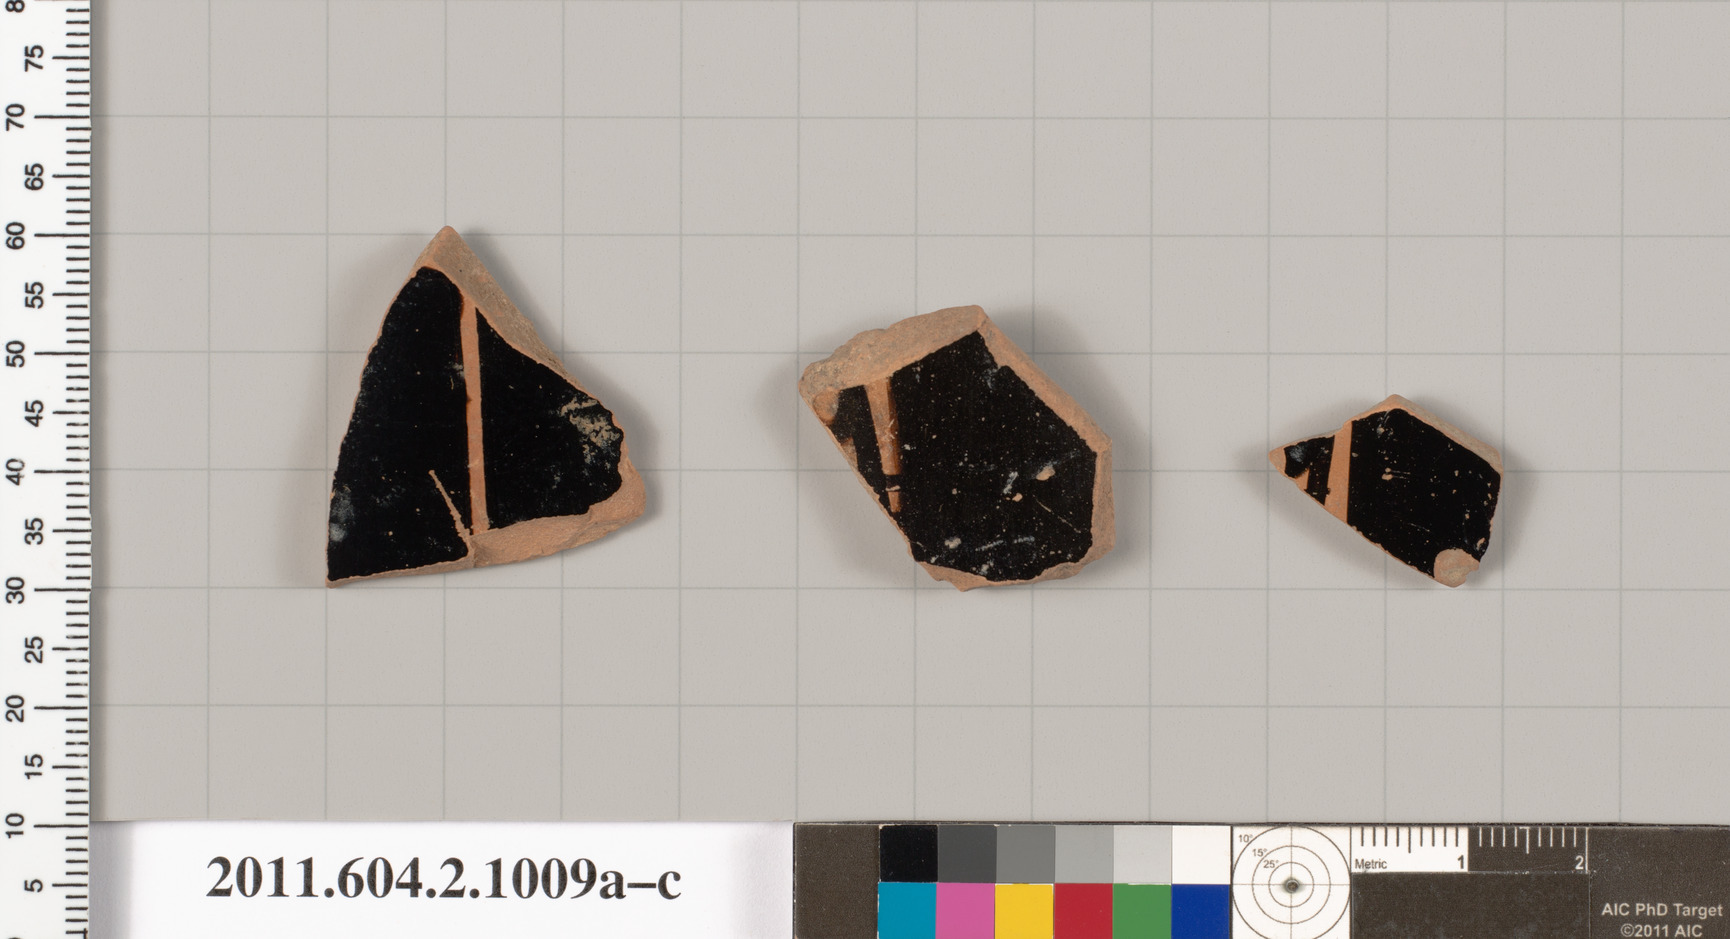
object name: oinochoe fragment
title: Terracotta fragments of oinochoai (jugs)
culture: greek, attic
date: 450-430 BCE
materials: terracotta